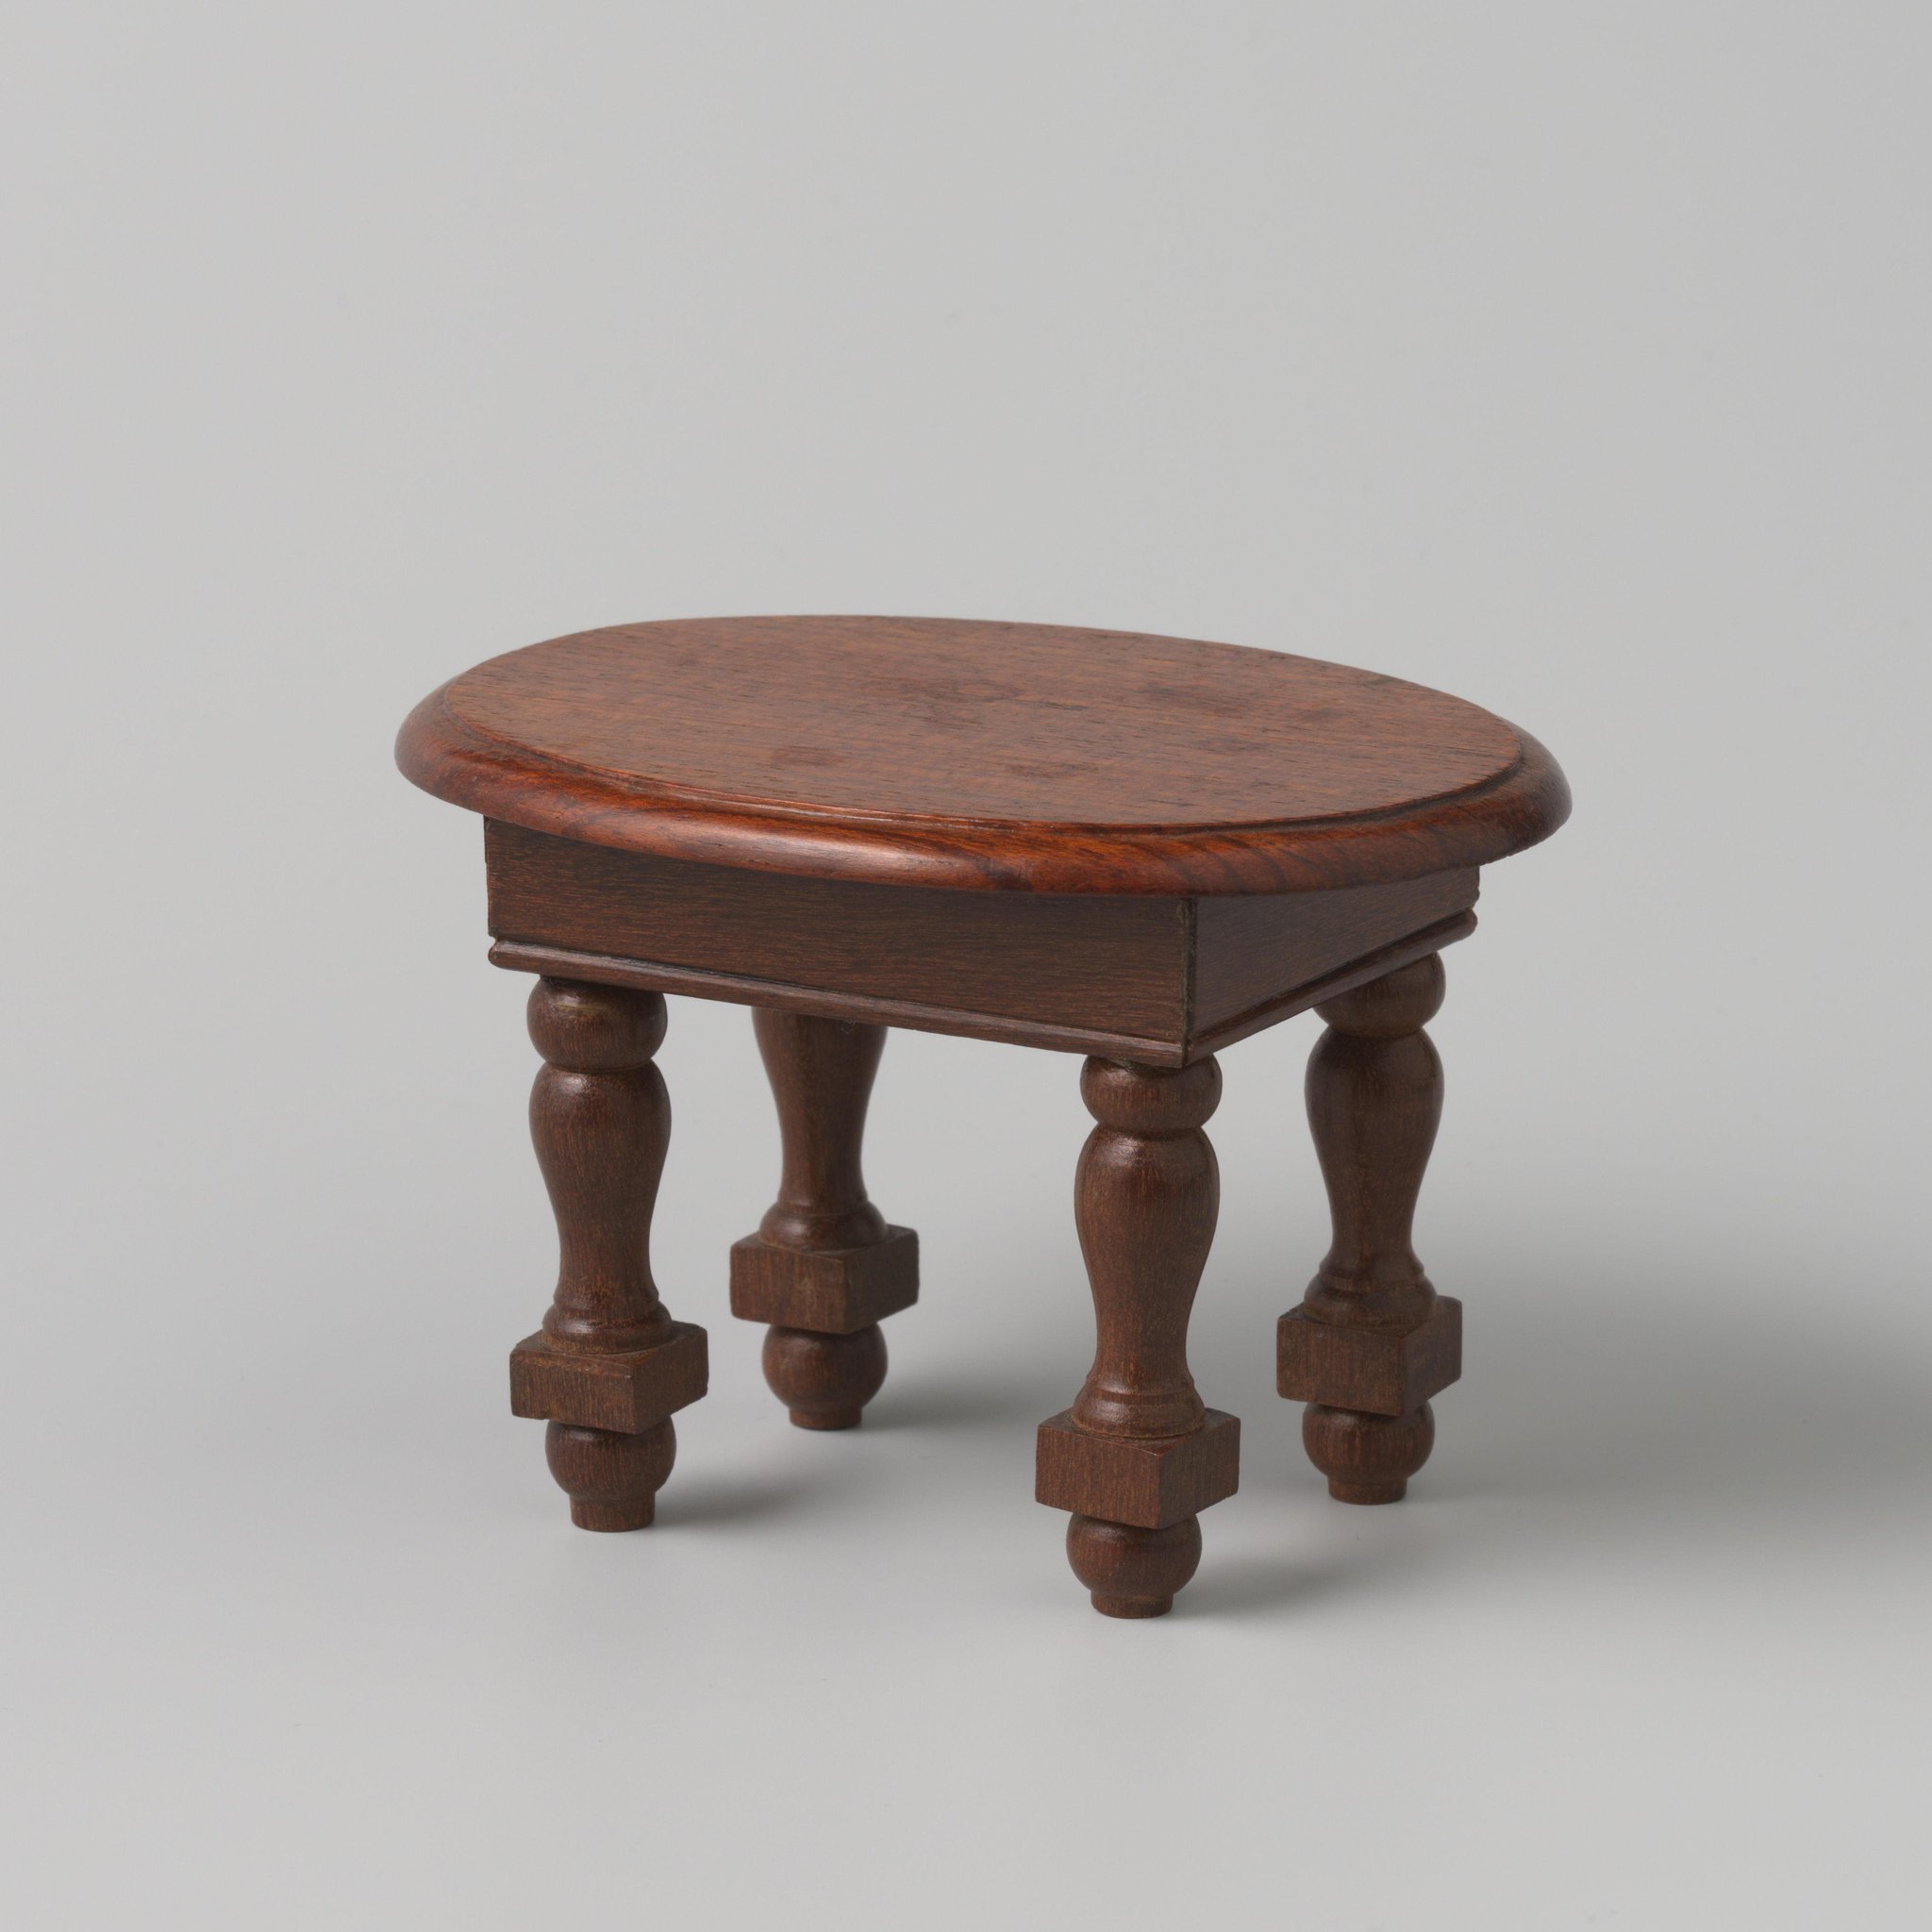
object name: table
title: Tafel met ovaal blad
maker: Anonymous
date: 1675-1699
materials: wood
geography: amsterdam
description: Tafel, vervaardigd van een tropische hardhoutsoort (bolletrie of bruinhart?), de tafel heeft een ovaal mahoniehouten blad, dat rust op een rechthoekig onderstel met vier balustervormig gedraaide poten met vierkante huizen, zonder verbindingsregels.